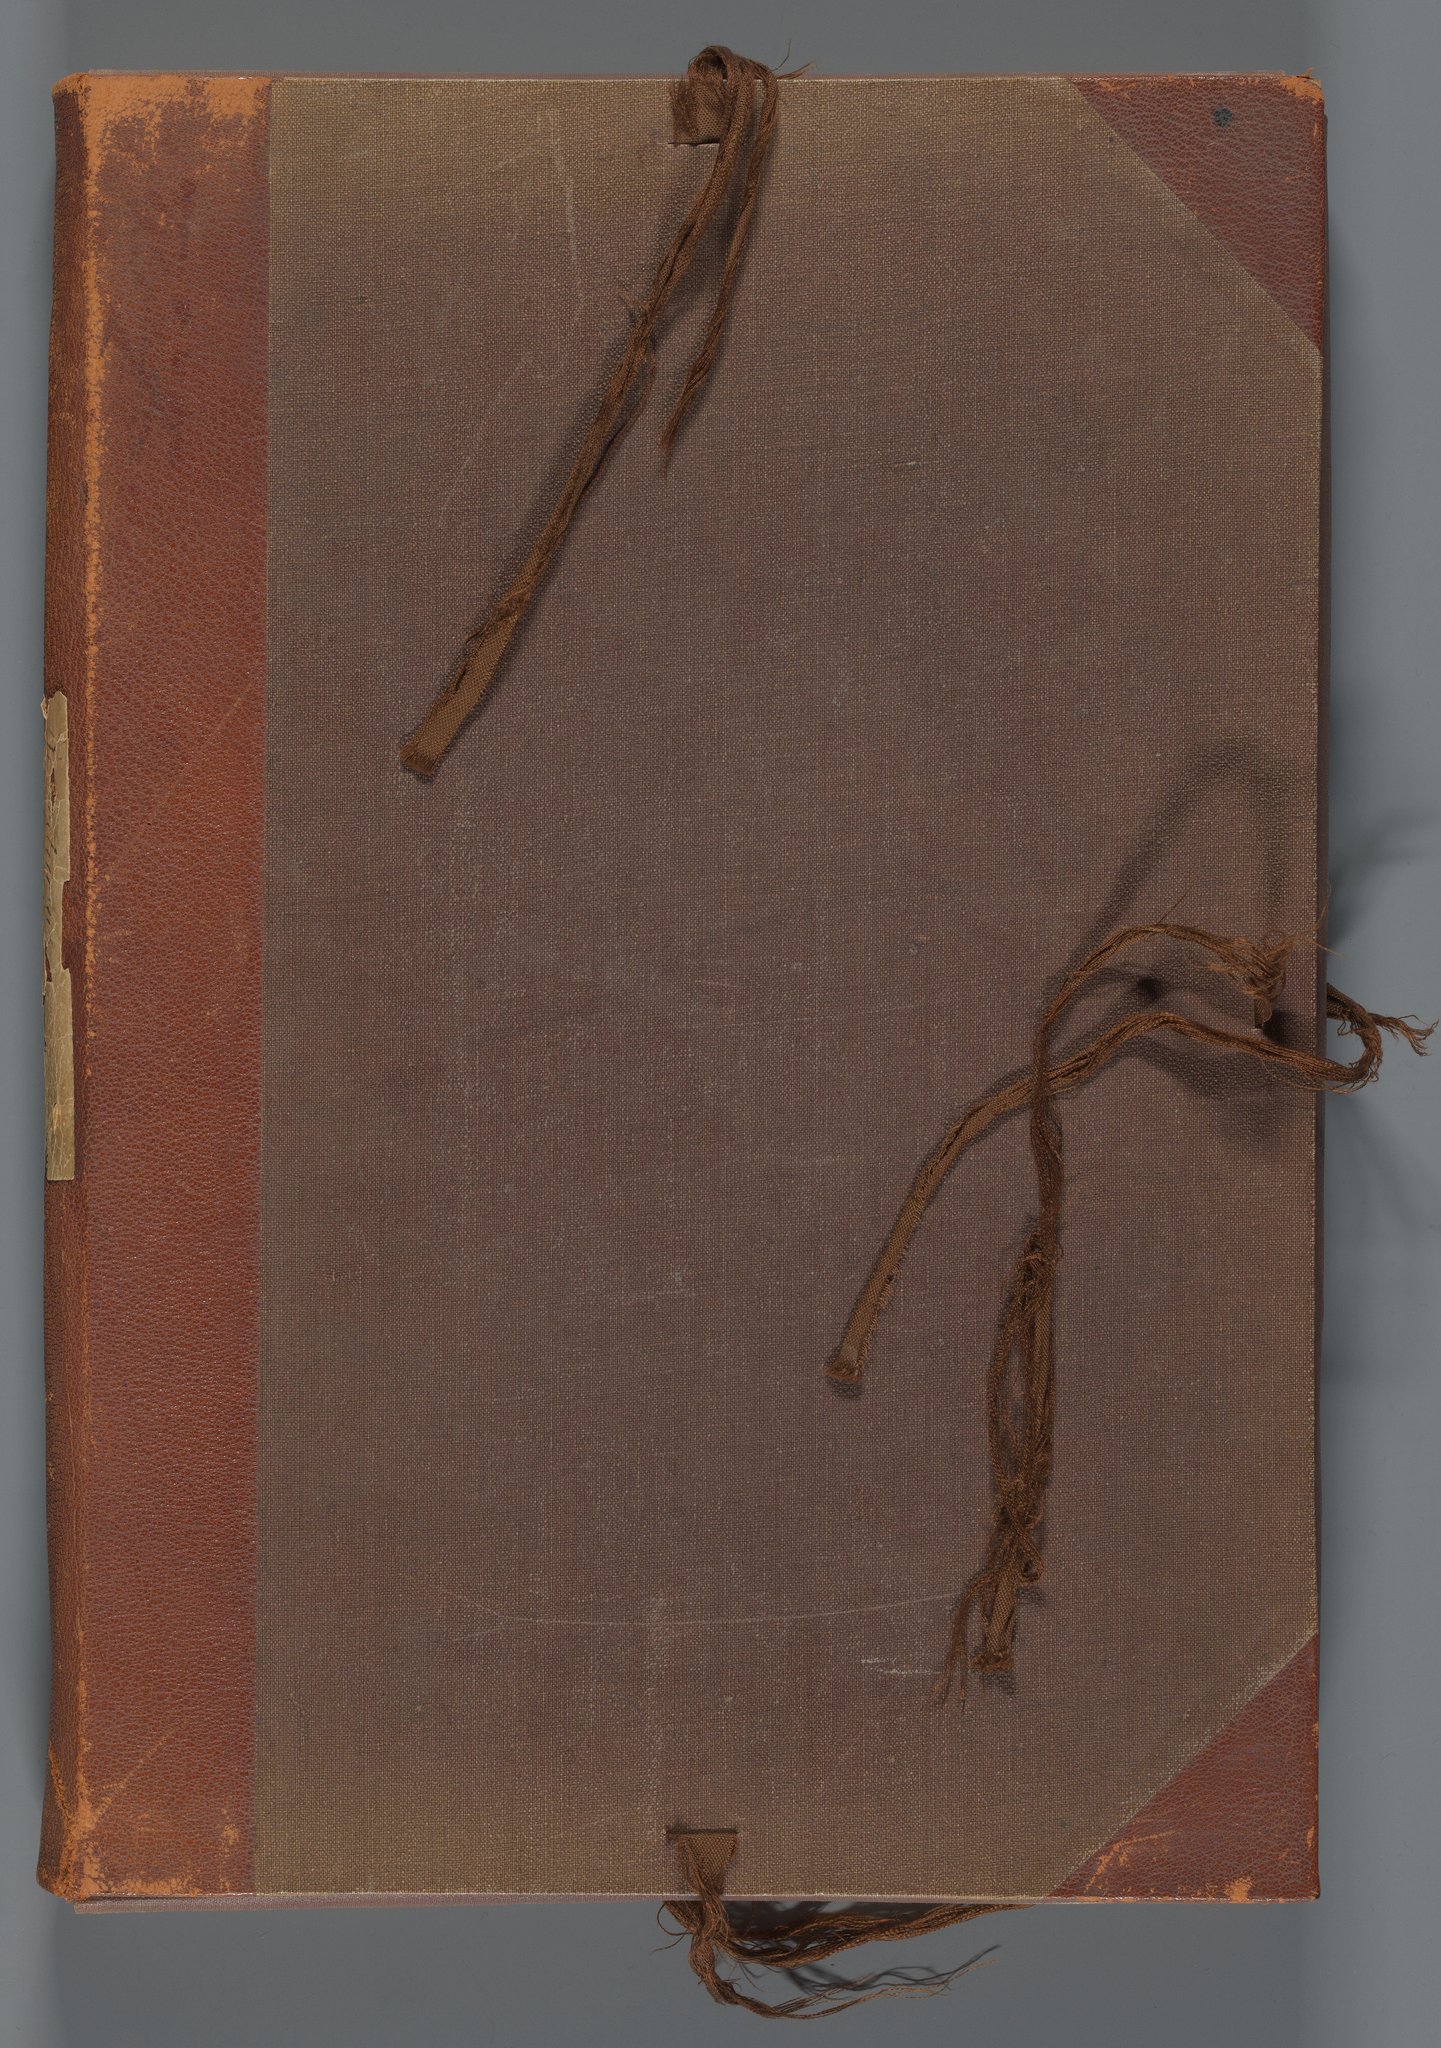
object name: photograph album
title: Omslag met 359 foto's van beeldhouwwerken uit het Germanisches Nationalmuseum, Neurenberg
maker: Anonymous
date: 1913-1930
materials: paper, cardboard, leather, textile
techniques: gelatin silver print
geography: marburg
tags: piece of sculpture, reproduction of a piece of sculpture, permanent exhibition, museum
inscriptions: inscription: ‘Reproducties/ Beeldhouwwerk[en]/ Germanisches Museum/ Nürnberg’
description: Omslag met 359 ontwikkelgelatinezilverdrukken van Middeleeuwse sculpturen uit het Germanisches Nationalmuseum in Neurenberg. 131 foto's zijn afgedrukt op 238 x 178 mm, 228 foto's meten 178 x 128 mm. Alle foto's hebben een afgedrukt nummer op recto, een handgeschreven nummer op verso en een stempel van de samensteller op verso. Van alle foto's is de fotograaf onbekend.